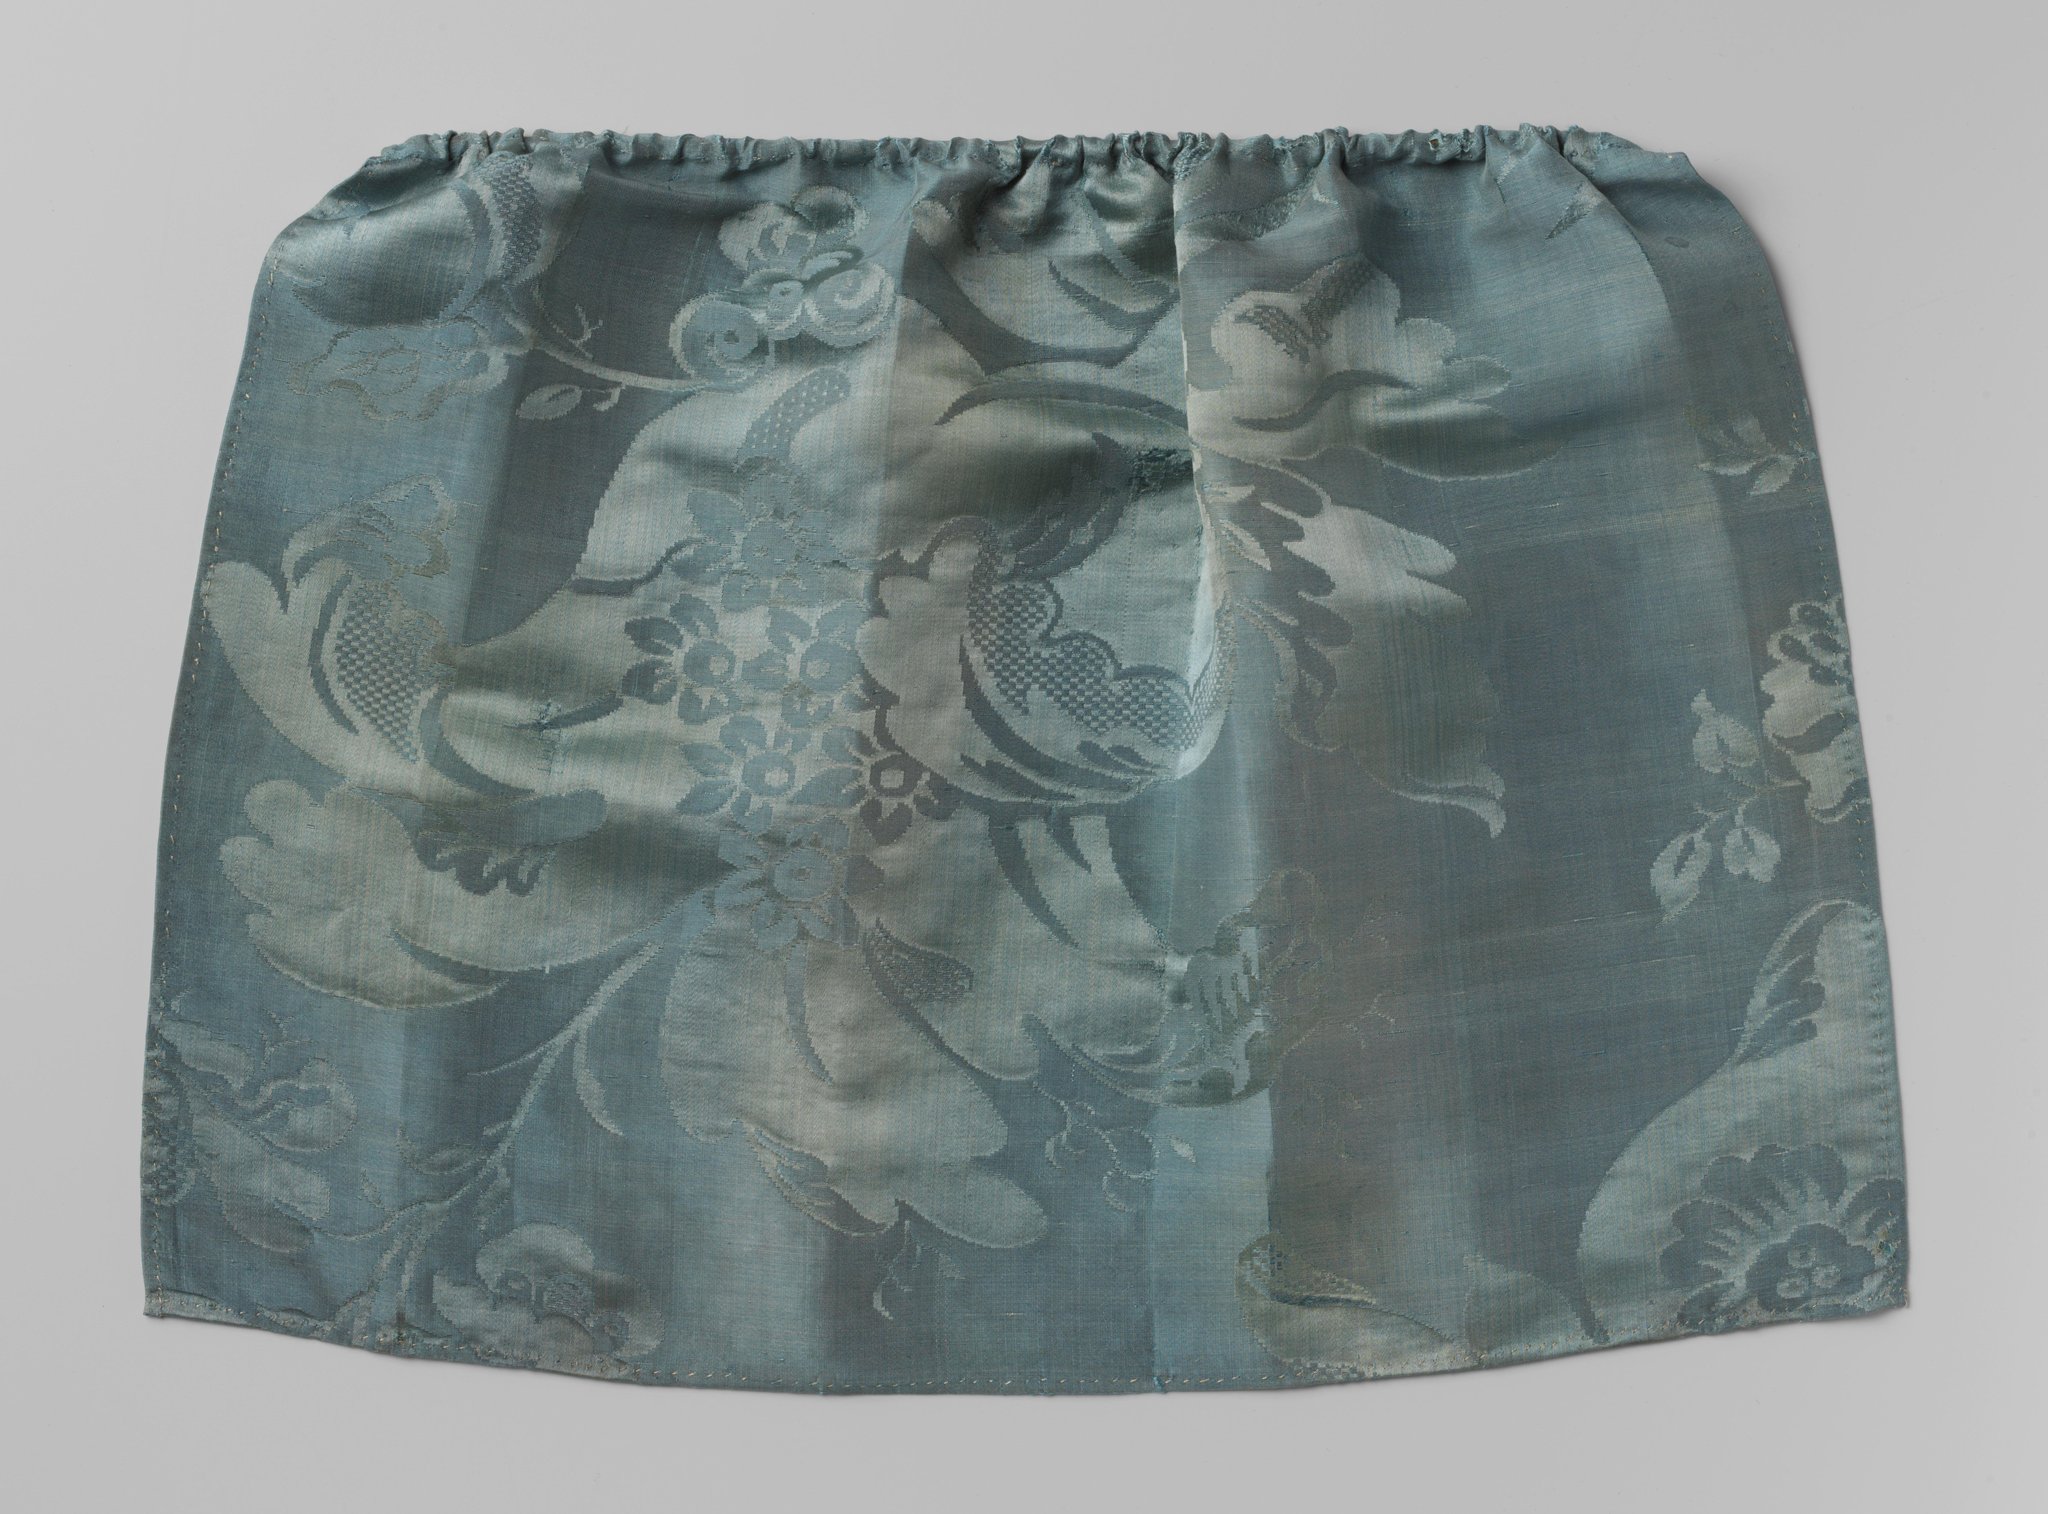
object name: miniature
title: Gordijn van groen-blauwe zijde aan roede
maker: Anonymous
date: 1750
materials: copper, silk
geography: france